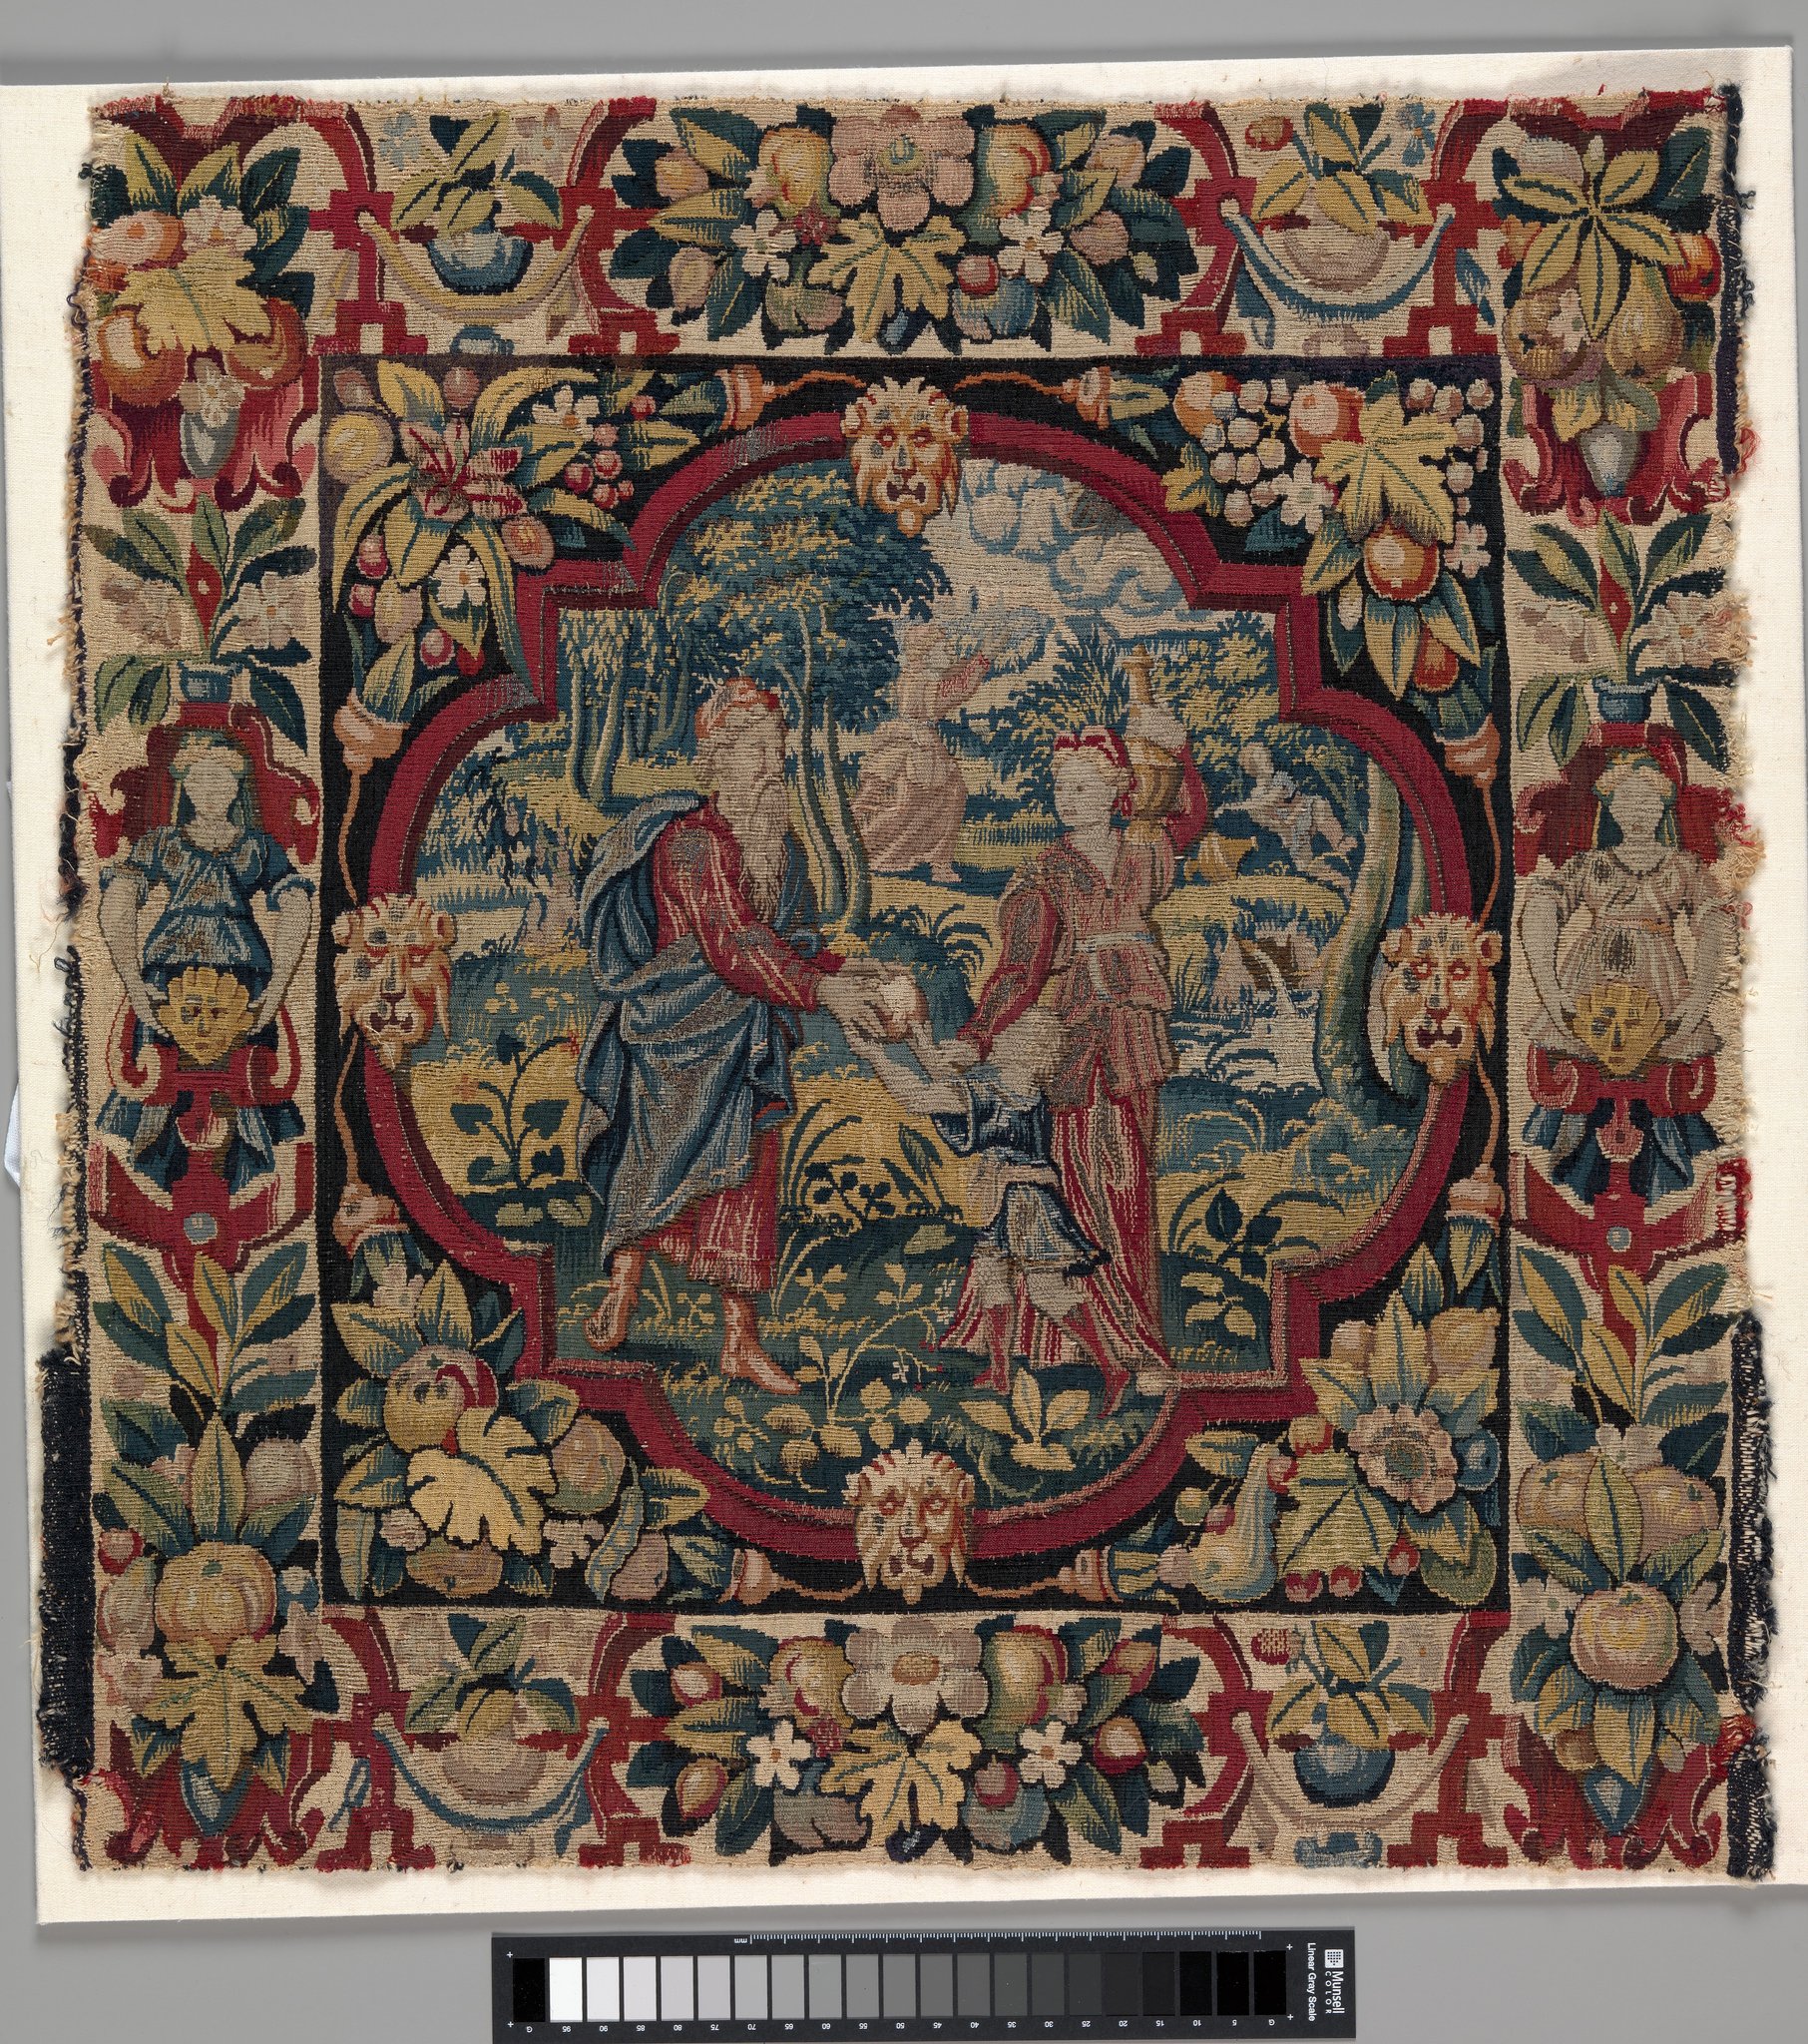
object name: cushion cover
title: The Expulsion of Hagar from the Story of Abraham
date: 1600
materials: silk, silver gilt, thread, wool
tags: men,women,flowers